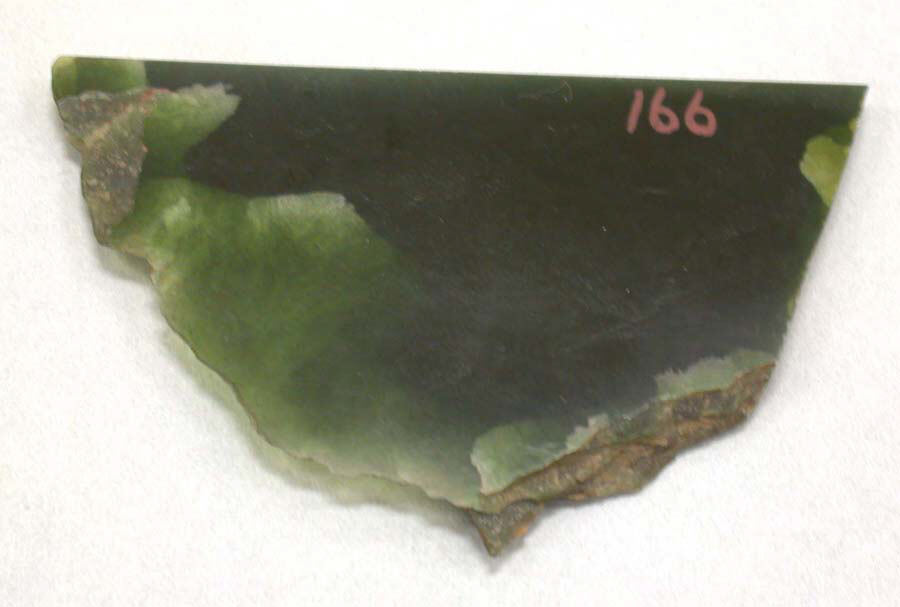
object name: fragment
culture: new zealander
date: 1902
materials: jade